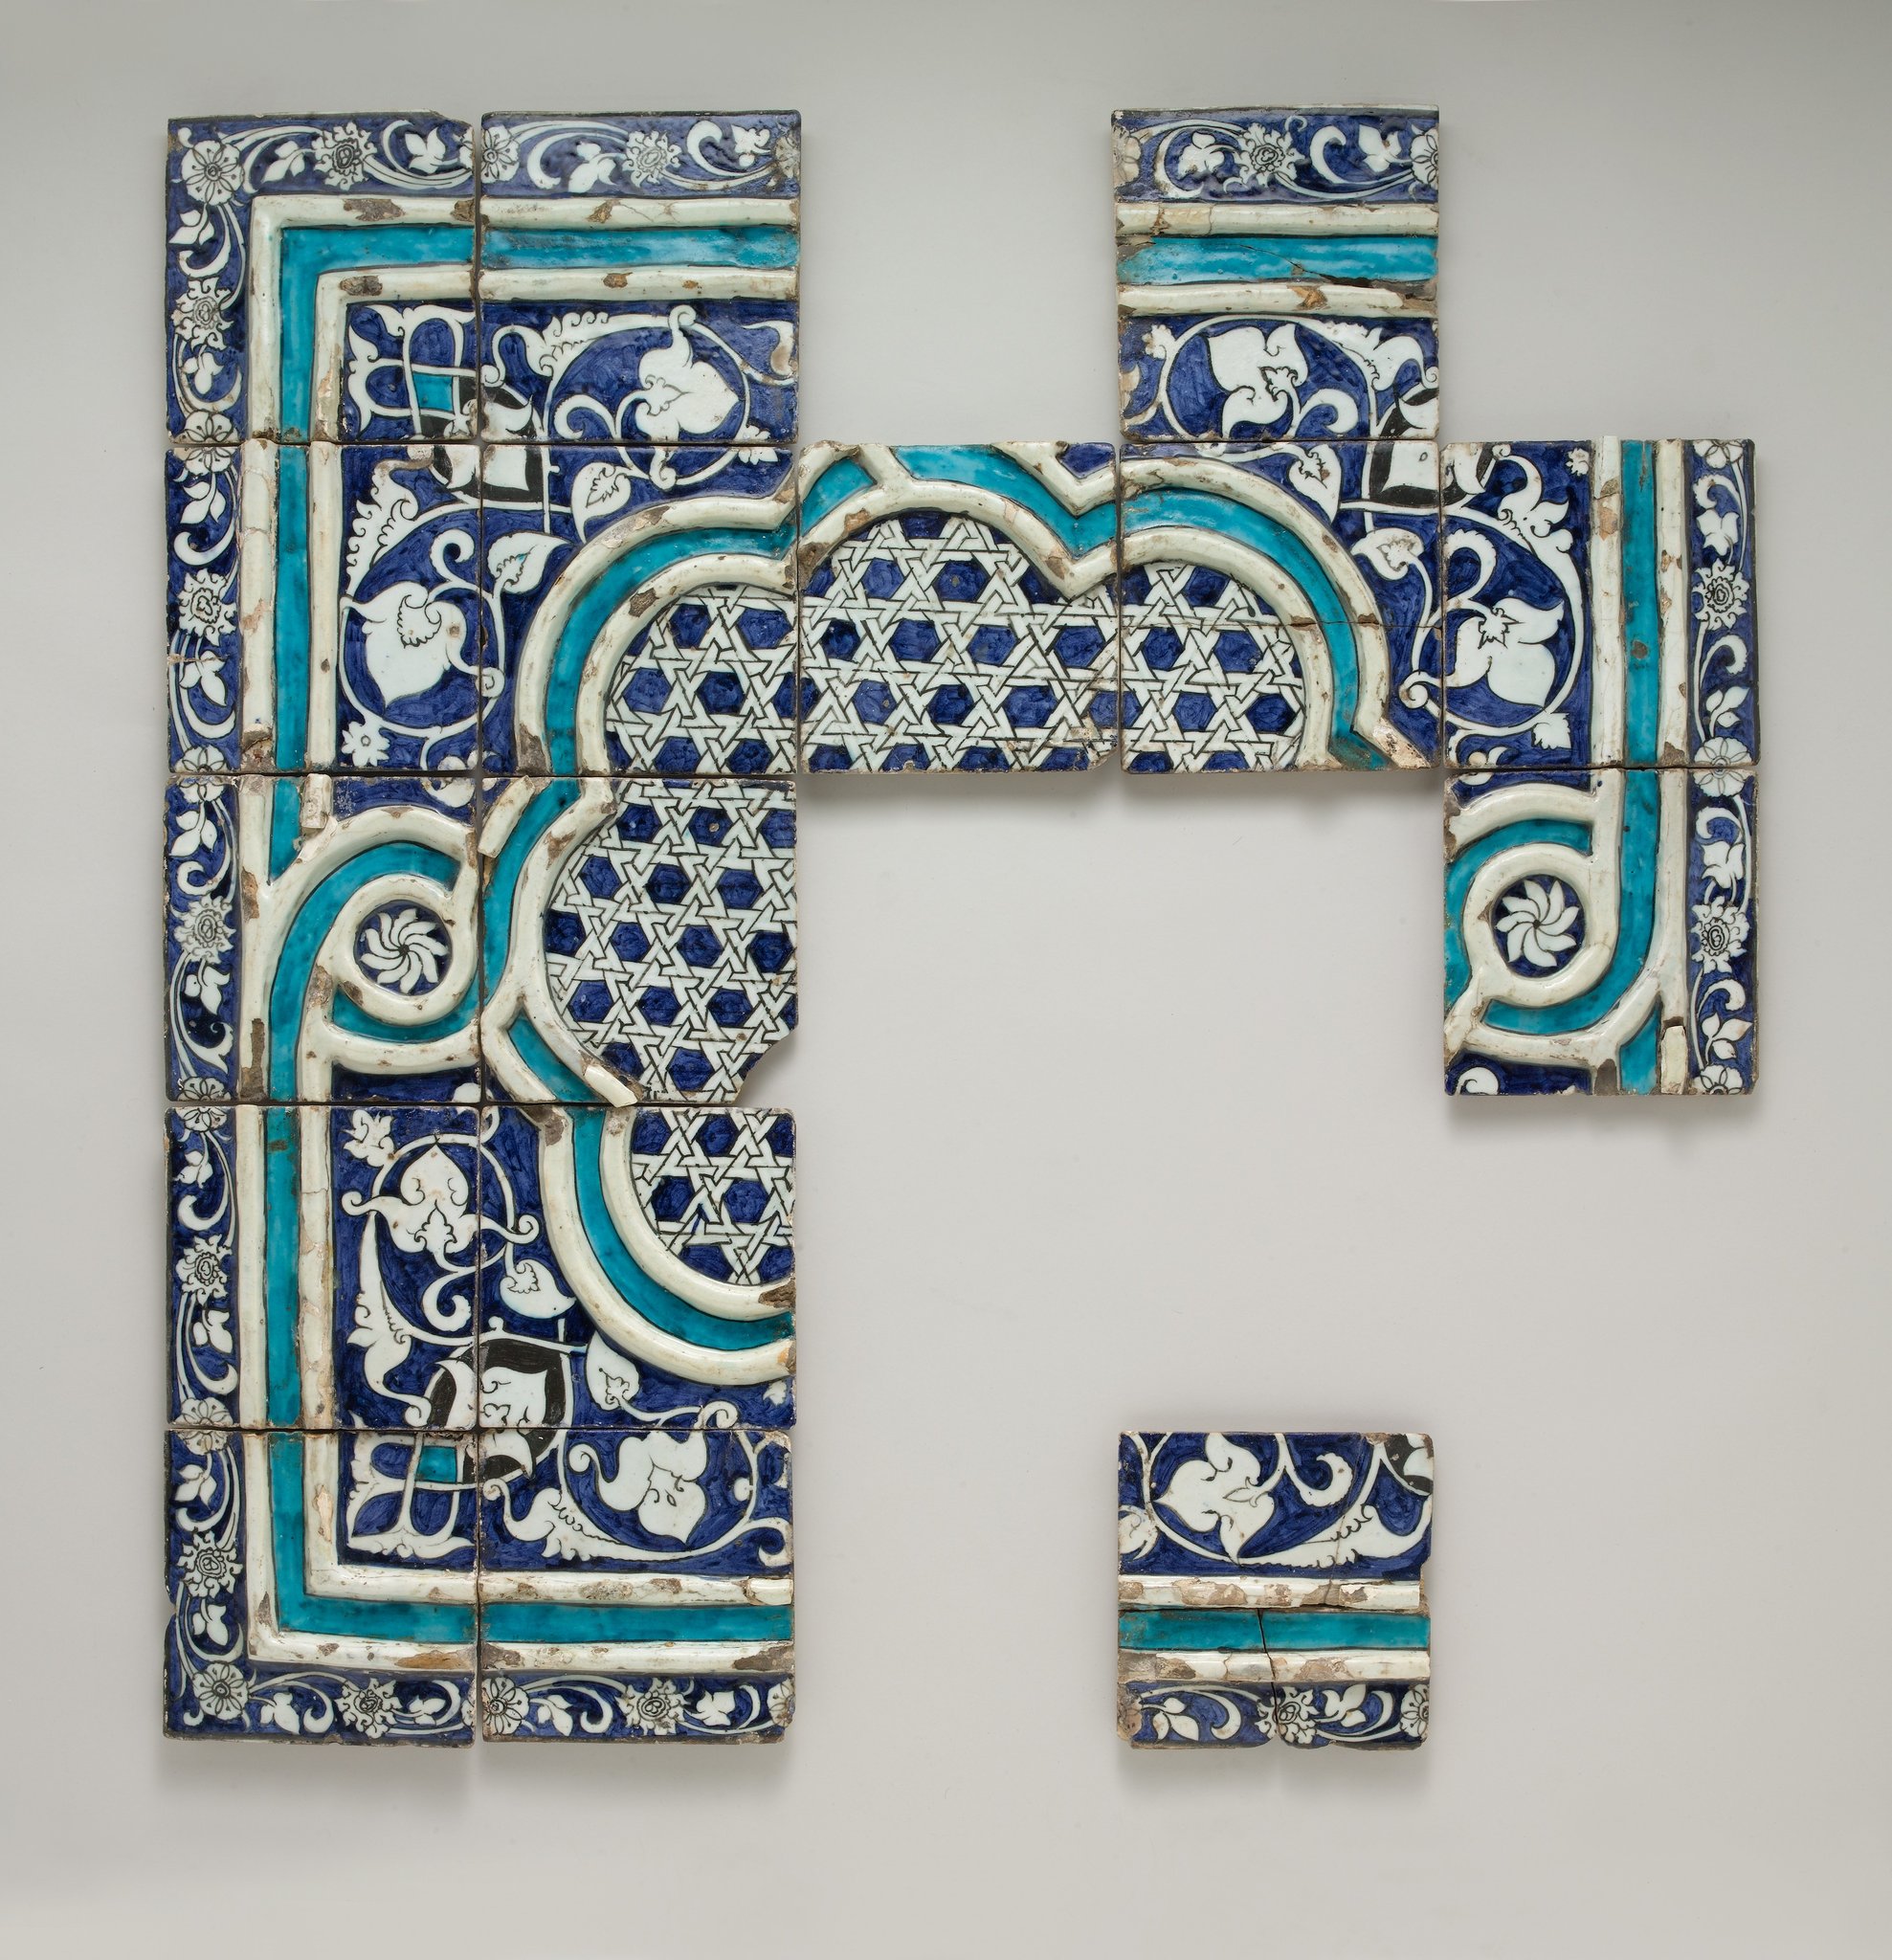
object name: tile panel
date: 1430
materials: glaze, stonepaste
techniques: painting, polychrome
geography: syria